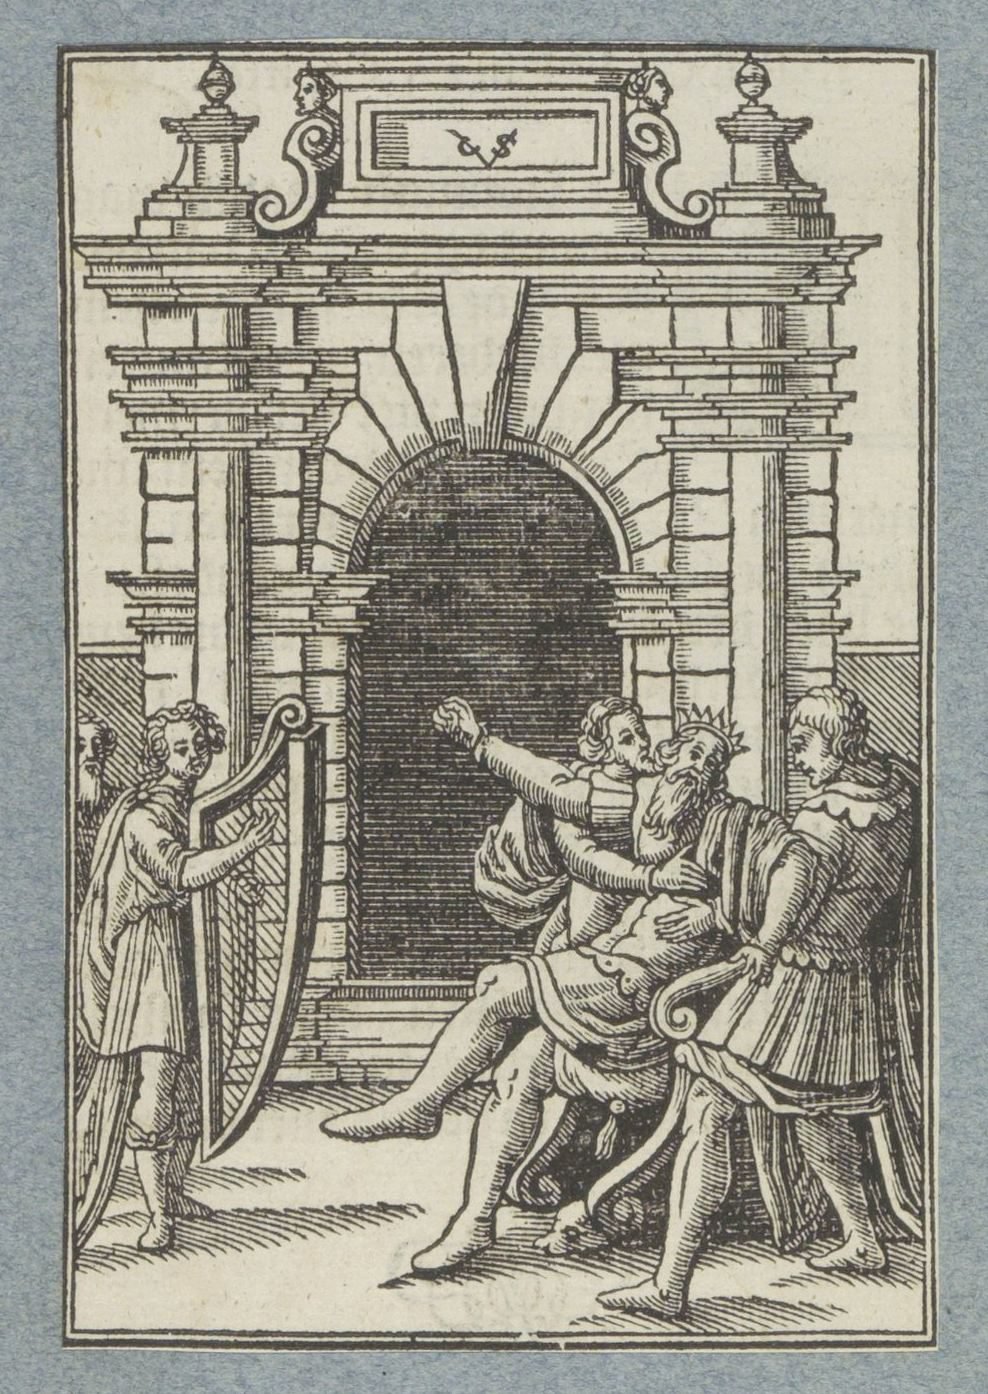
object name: print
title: David speelt harp voor Saul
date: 1645-1646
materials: paper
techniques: letterpress printing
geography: amsterdam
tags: david playing his harp before saul, saul troubled by an evil spirit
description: De prent werd gemaakt voor de uitgaven van P.J. Paets uit Amsterdam. Ze komt in ieder geval voor in: Bibels Tresoor ofte der zielen lusthof. Amsterdam, P.J. Paets, 1646. Mogelijk ook in: Historien ende Prophetien. [Amsterdam], P.J. Paets, 1645.